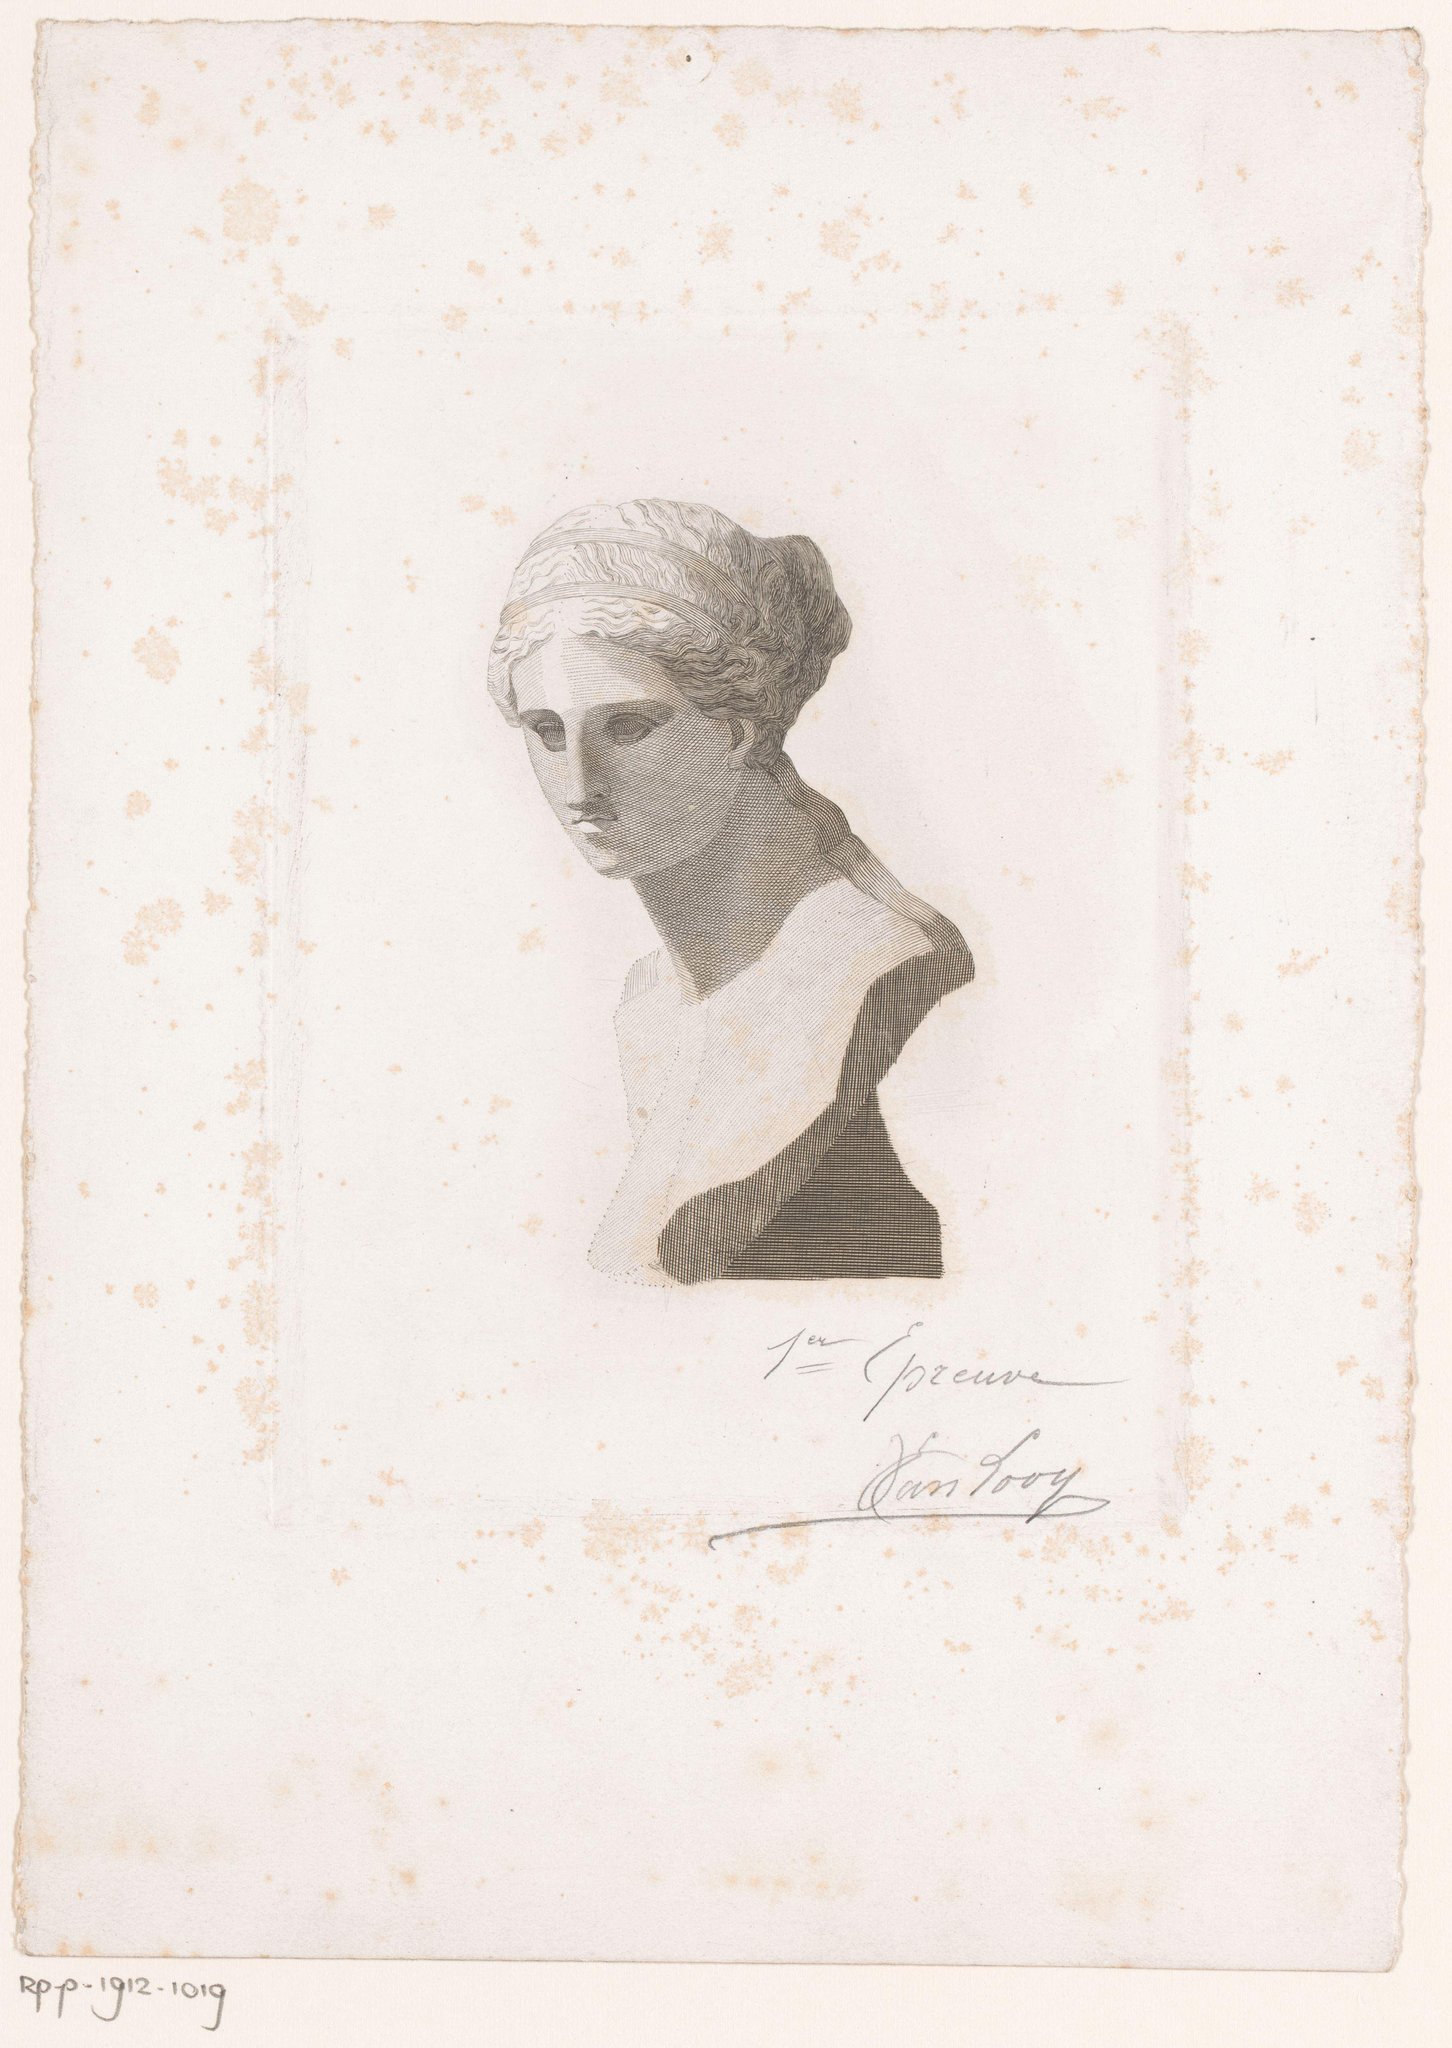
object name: print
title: Buste van Venus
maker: joseph edouard van looy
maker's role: print maker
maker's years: 1871-1896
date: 1881-1912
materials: paper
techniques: etching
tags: (story of) venus (aphrodite), chest, bust - aa - female human figure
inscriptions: collector's mark: Lugt 2228, annotation: ‘1er Epreuve’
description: Sterfdatum van de prentmaker is onbekend. Daarom is voor de bepaling van de rechten van dit object gebruik gemaakt van de verwervingsdatum Rijksmuseum Amsterdam.